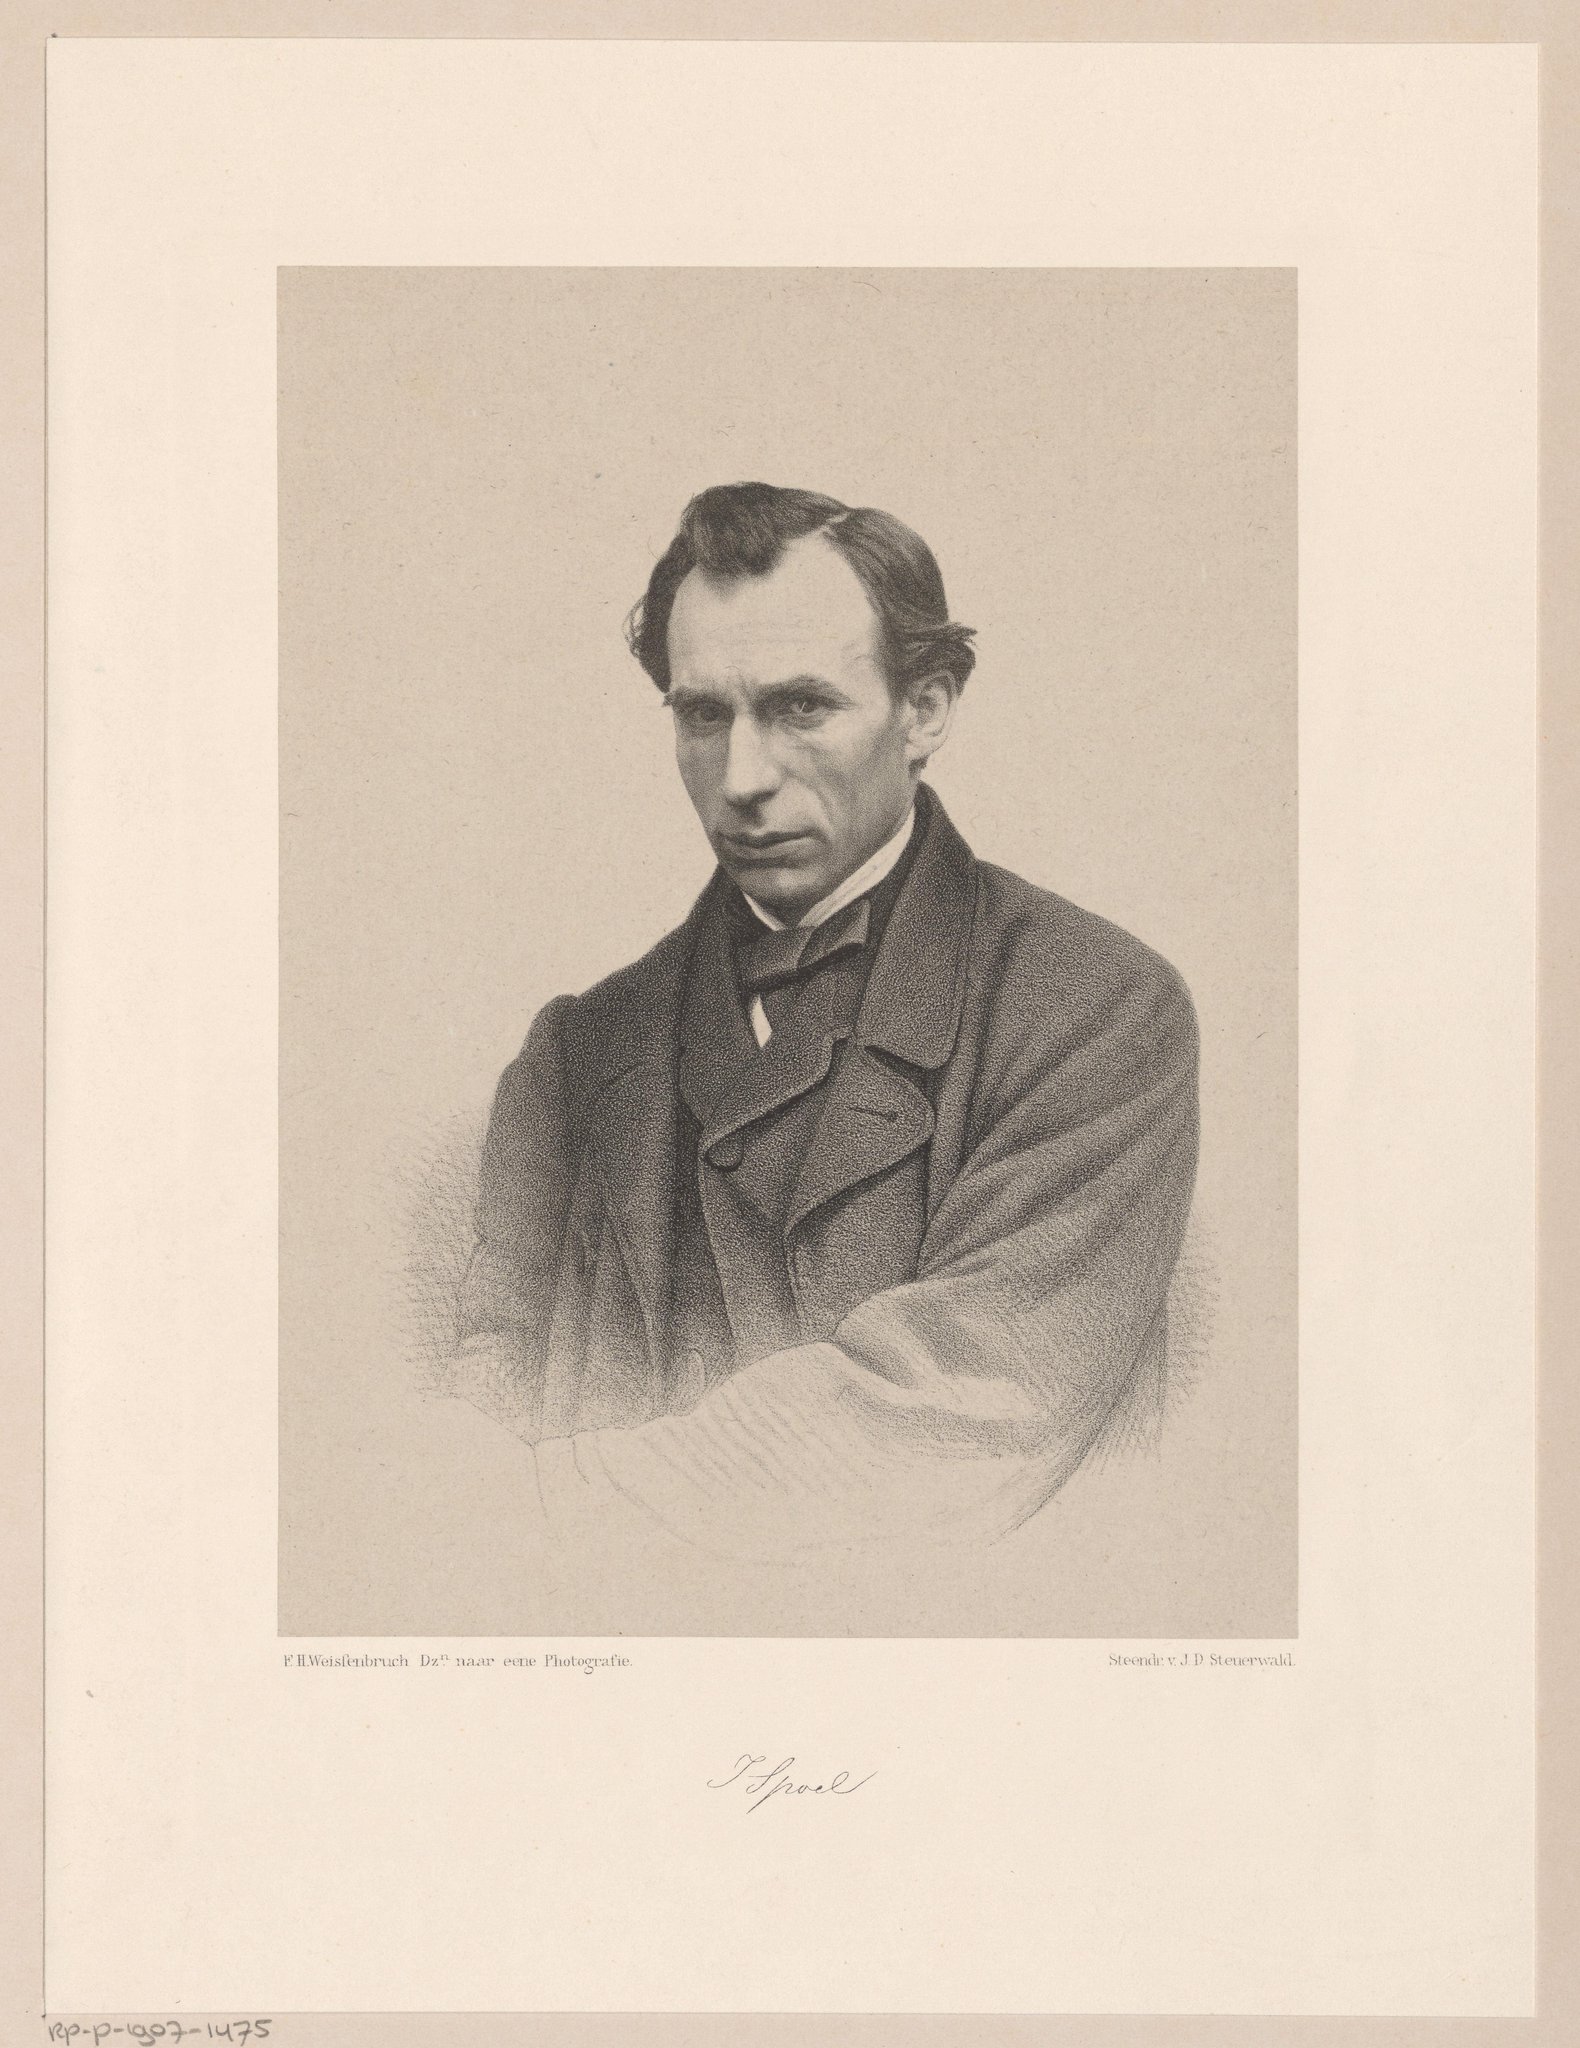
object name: print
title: Portret van Jacob Spoel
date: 1850-1863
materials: paper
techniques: lithograph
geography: the hague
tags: rotterdam, painter, historical persons, portrait, self-portrait of artist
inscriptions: collector's mark: Lugt 2228